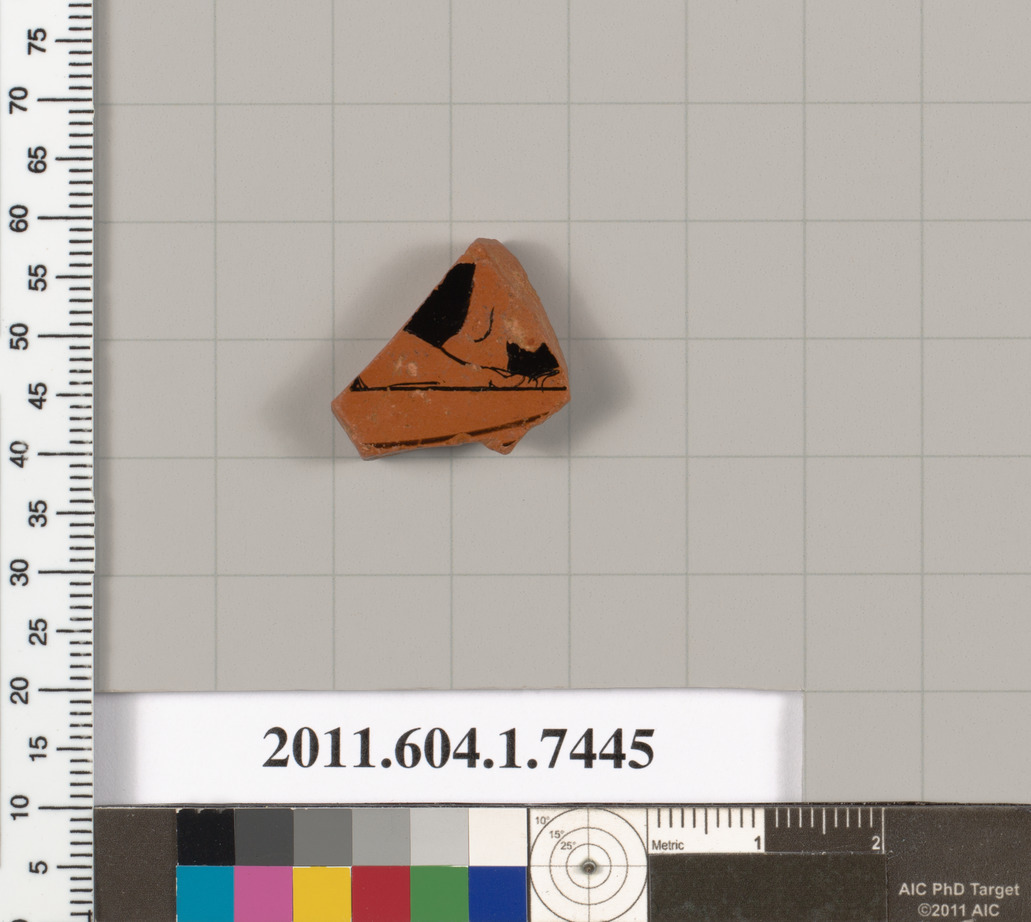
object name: kylix fragment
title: Terracotta fragment of a kylix (drinking cup)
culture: greek, attic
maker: painter of acropolis 356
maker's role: artist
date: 490-470 BCE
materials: terracotta